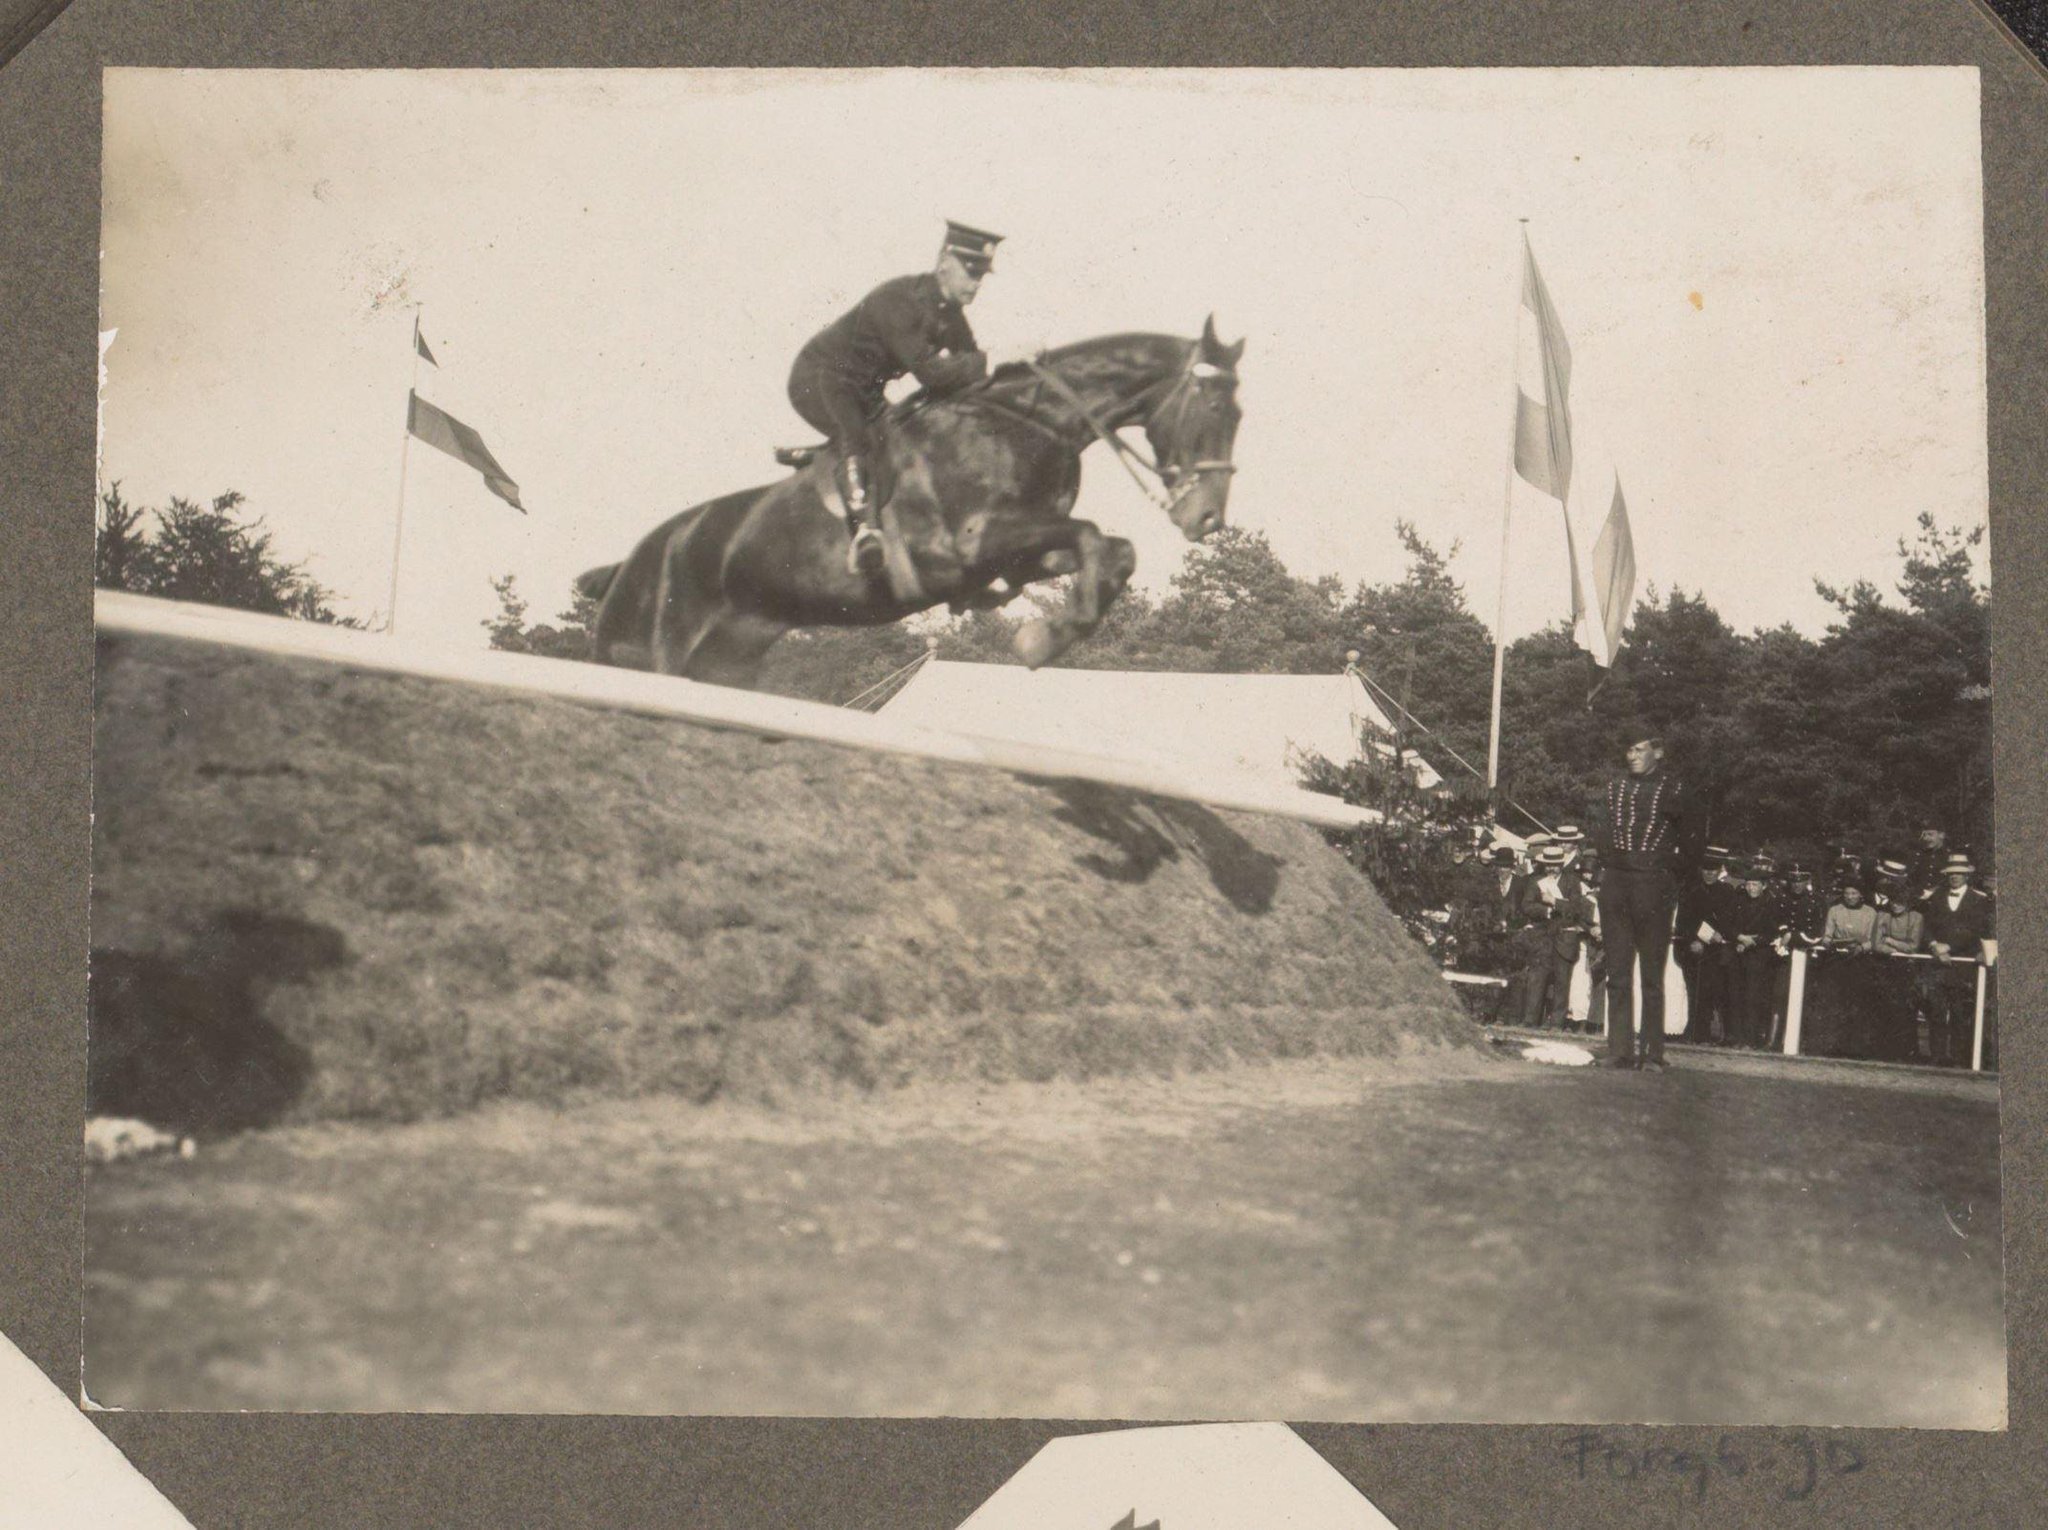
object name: album leaf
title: Ruitertafereel op Koninklijke Houtvesterij Het Loo: geüniformeerde ruiter neemt hindernis op renbaan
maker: Anonymous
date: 1900-1925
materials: photographic support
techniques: gelatin silver print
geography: het loo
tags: riding a horse, ass, or mule; rider, horseman, crowd, mob, hunting, chase, hunting-ground, horse-racing, race-track, jumping (horse in motion)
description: Onderdeel van Fotoalbum van de heer Brams, opperhoutvester van koningin Wilhelmina op Koninklijke Houtvesterij Het Loo.